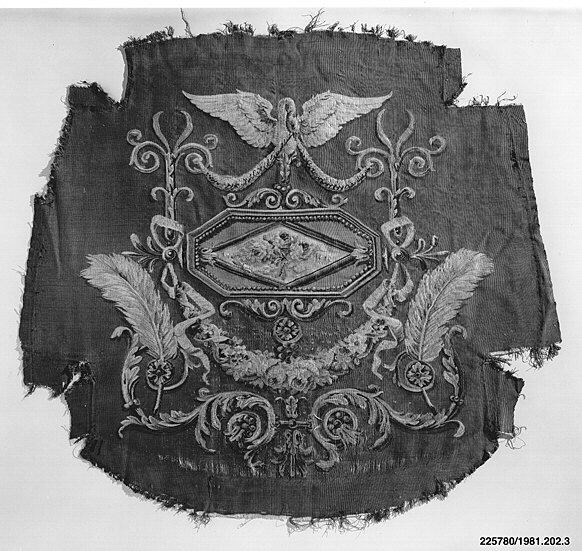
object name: upholstery panel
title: Chair seat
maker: beauvais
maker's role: manufactory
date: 1810-1820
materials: silk, wool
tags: birds,feathers